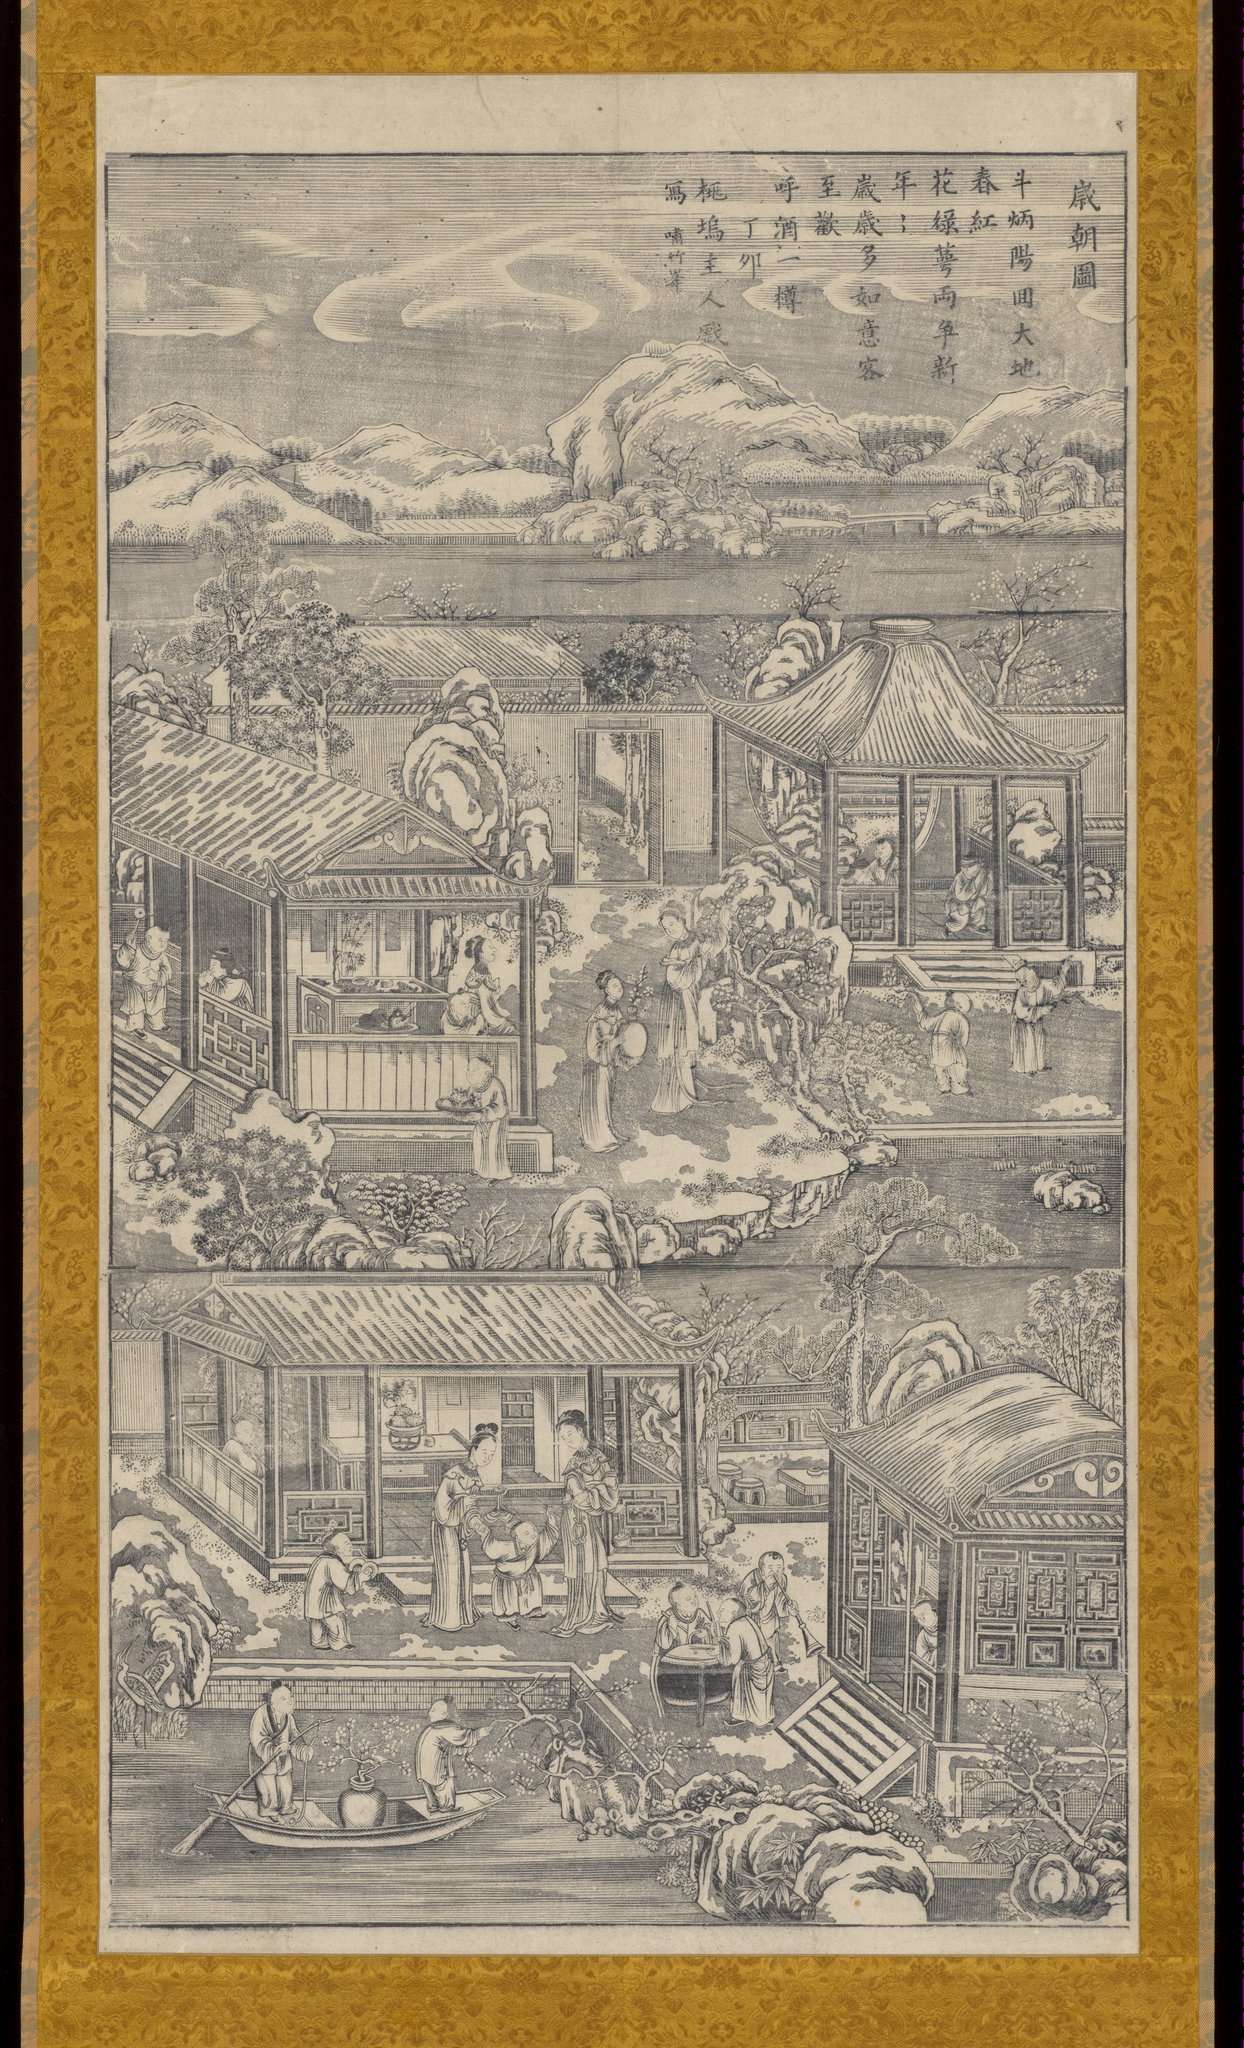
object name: print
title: New Year's Morning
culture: chinese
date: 1747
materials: ink, paper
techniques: woodblock print